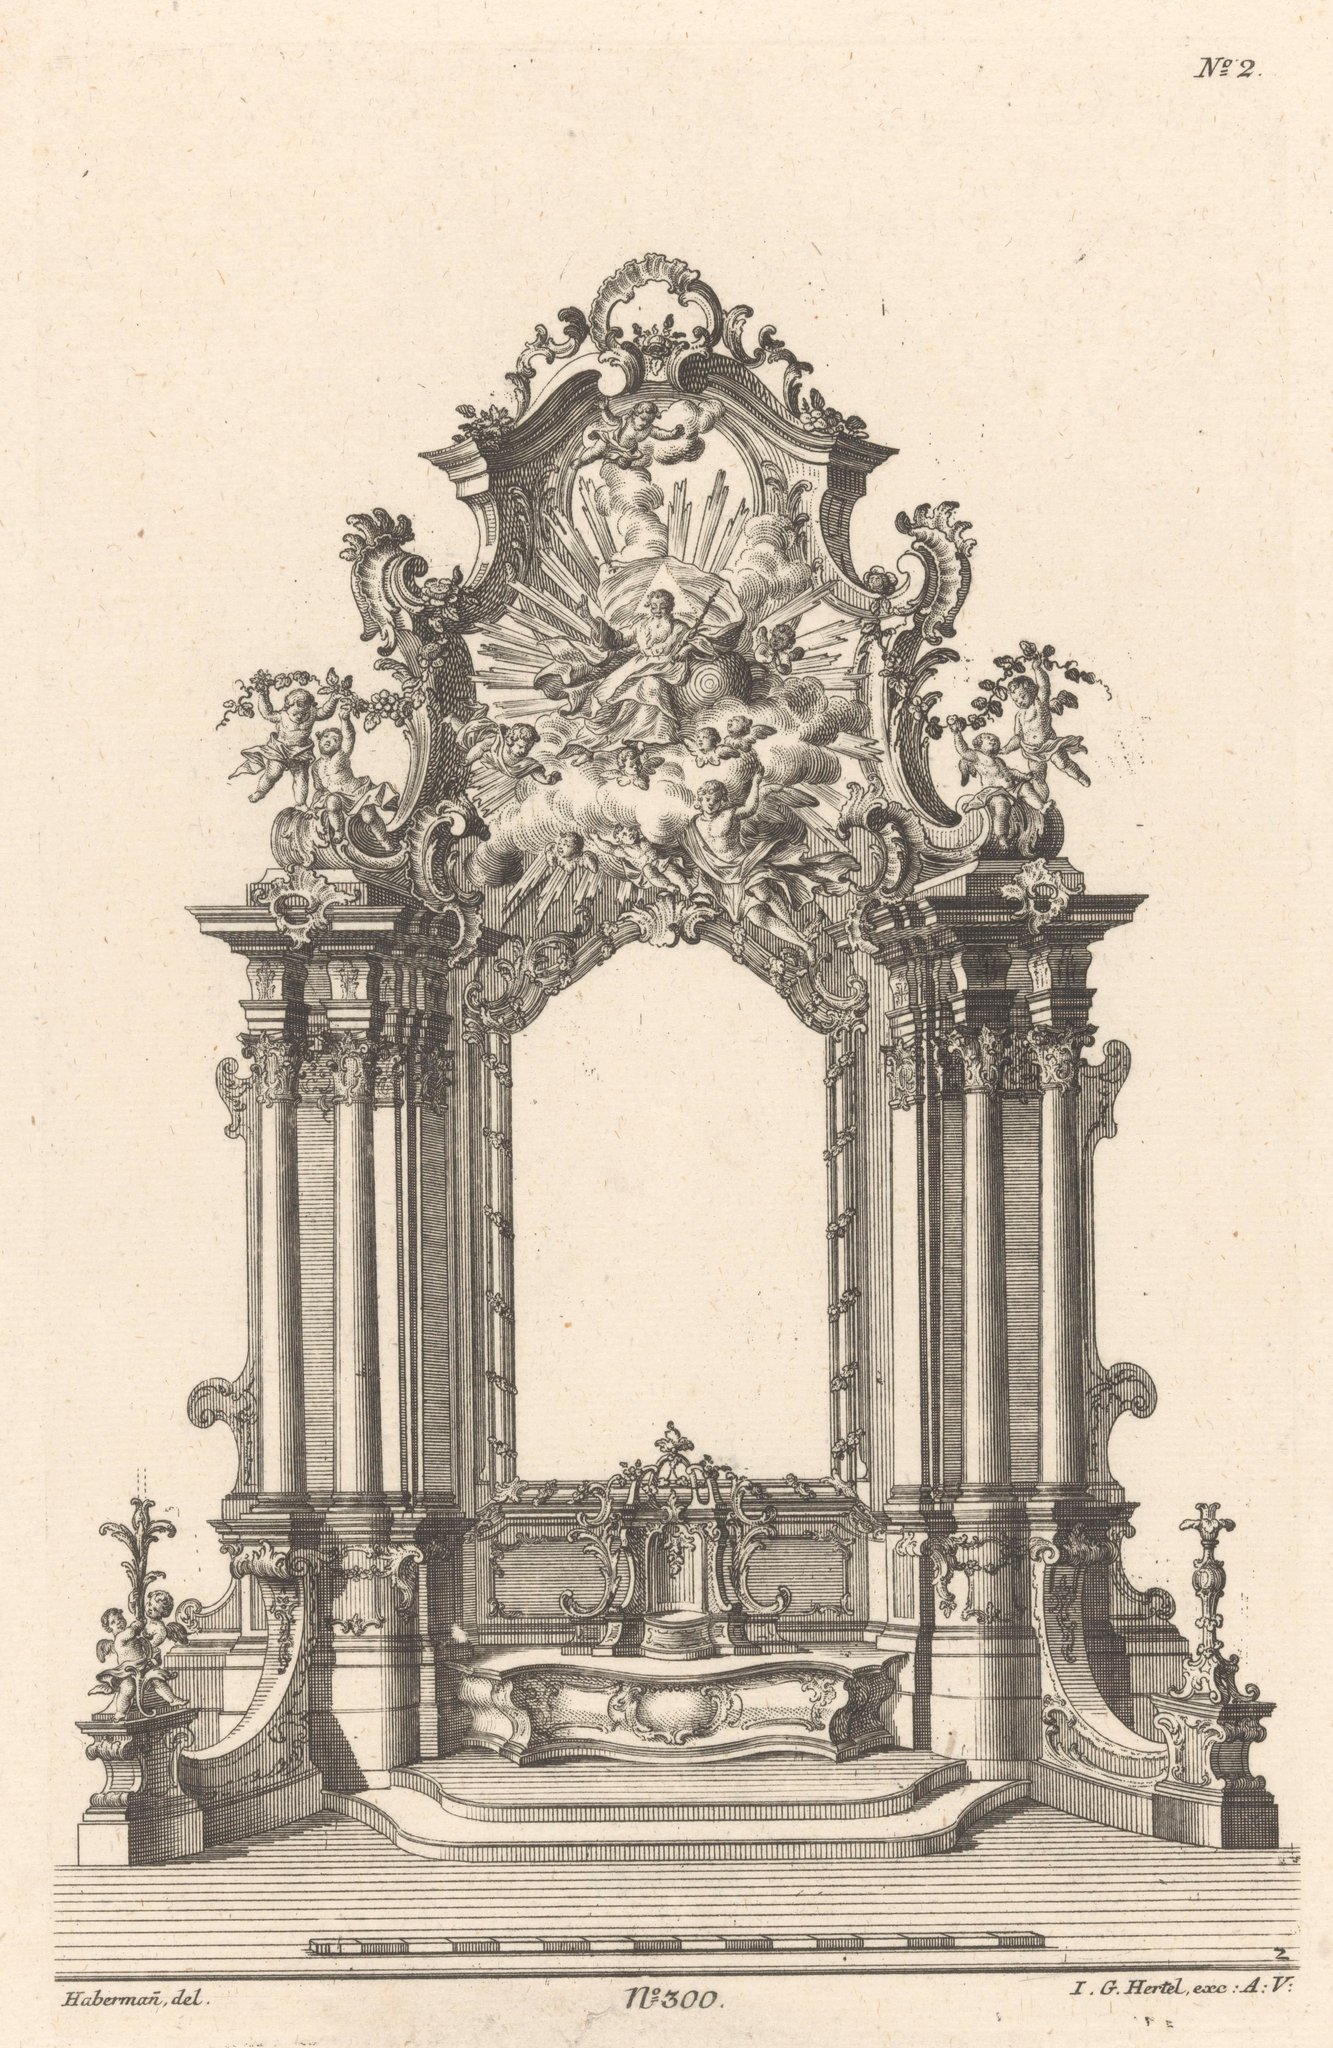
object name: print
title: Altaren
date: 1740-1745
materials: paper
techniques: engraving, etching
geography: augsburg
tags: god the father as bearded old man, usually with crown or tiara or sceptre and/or globe, altar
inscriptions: collector's mark: Lugt 2228, collector's mark: Lugt 2760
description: Altaar met rocaille ornamenten en God de Vader met globe in stralenkrans omgeven door gevleugelde putti. Uitgeversnummer 300.